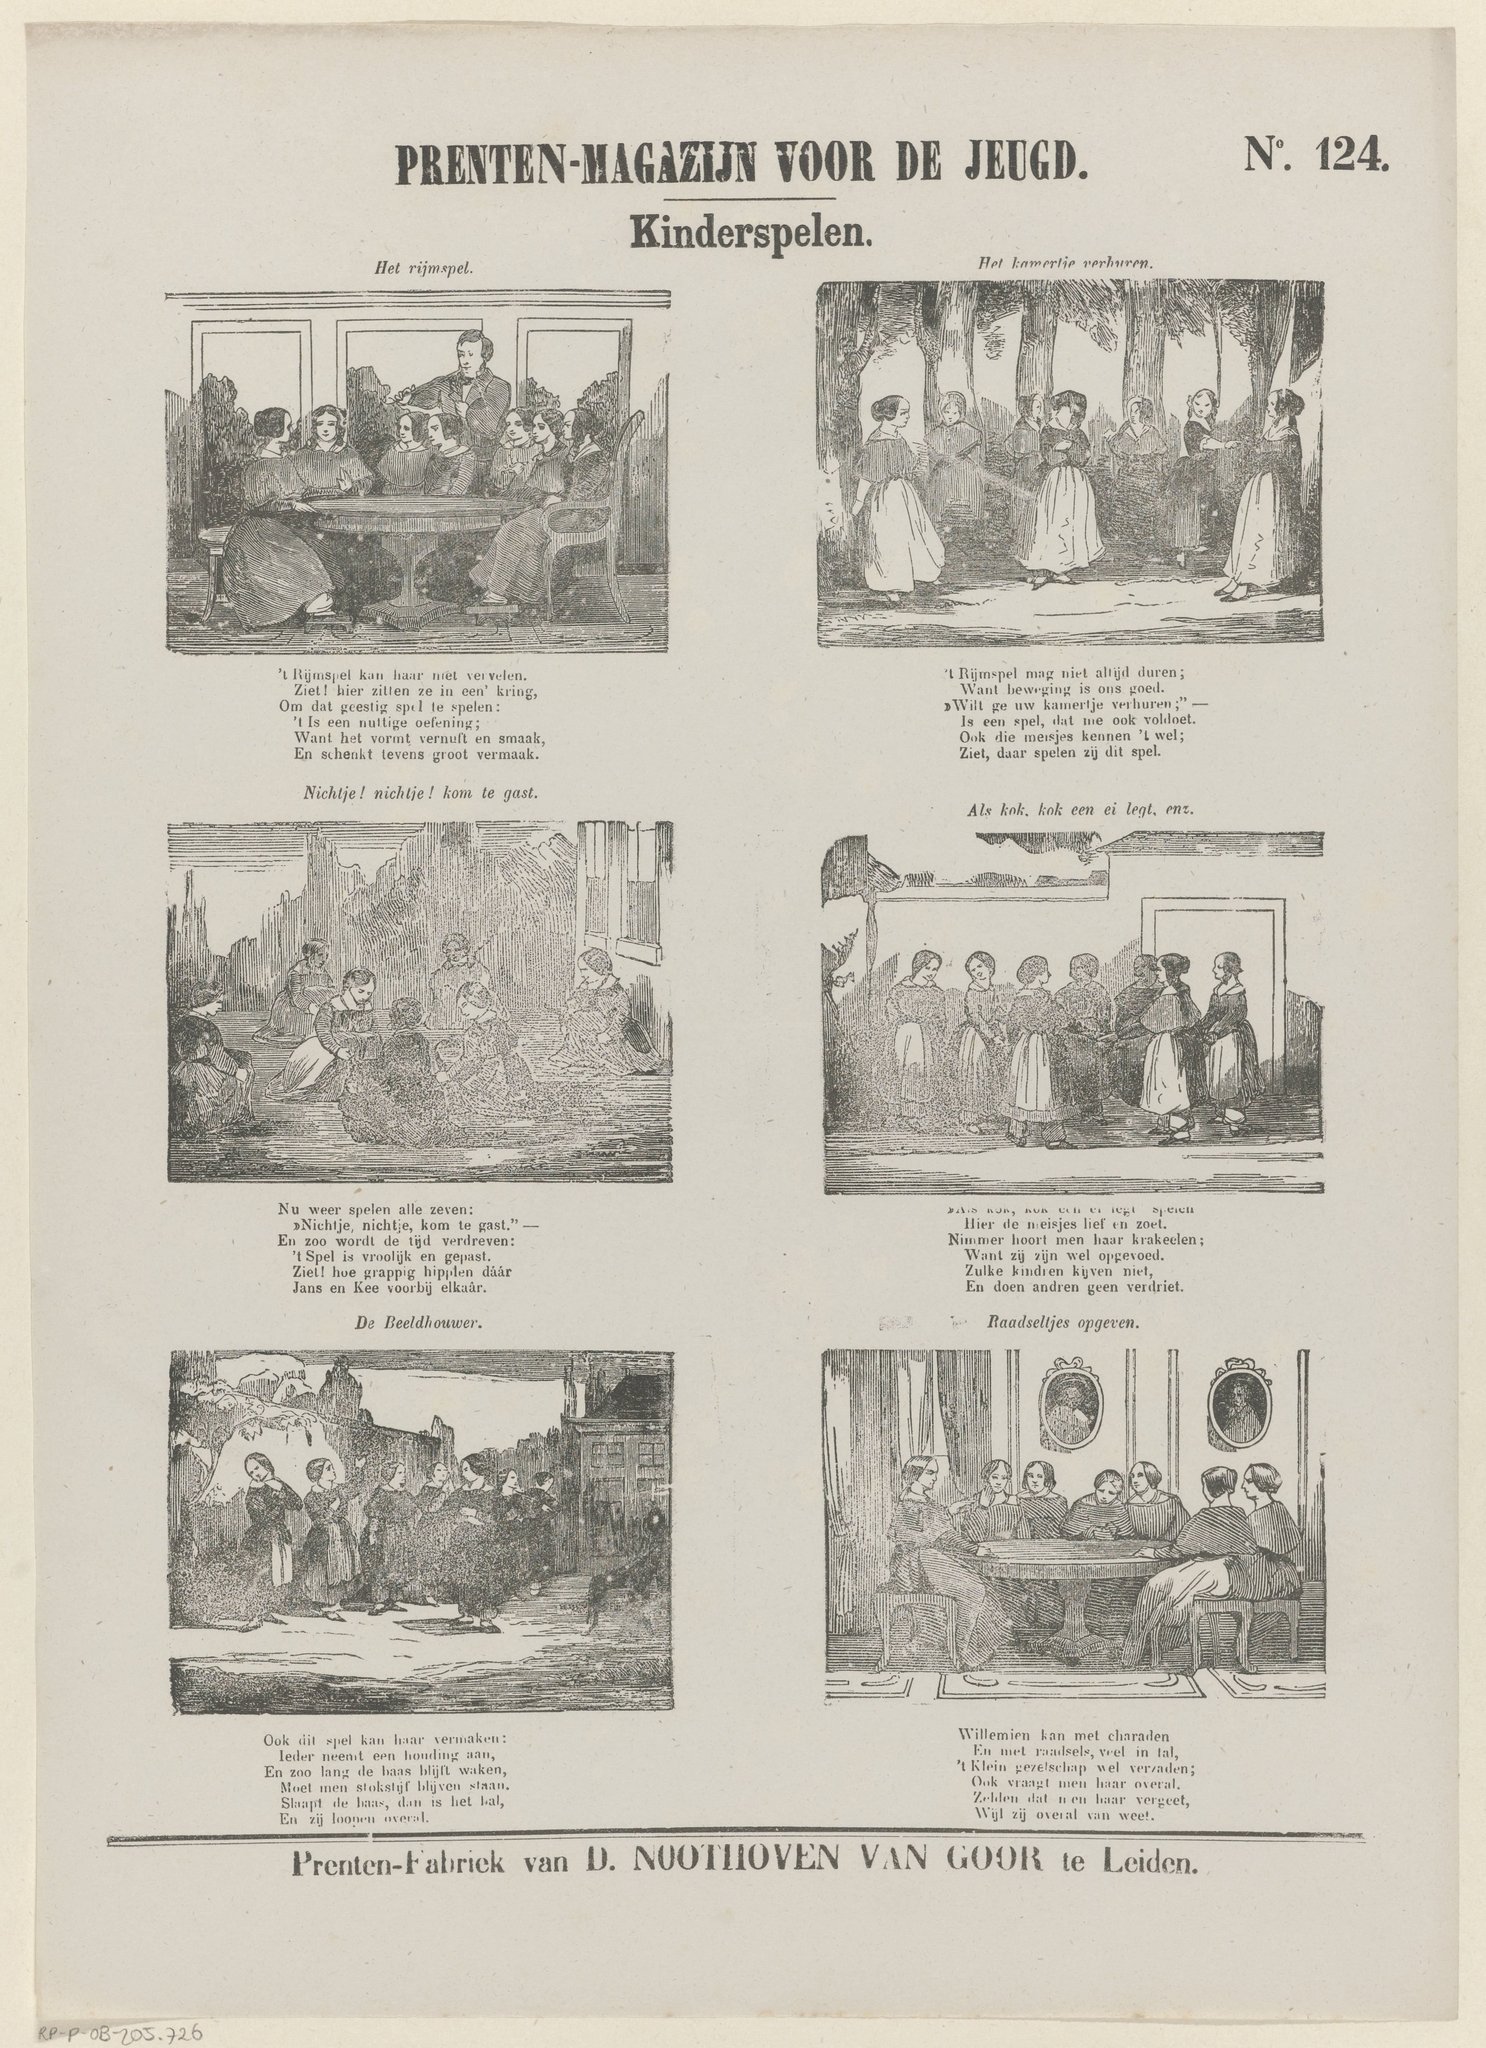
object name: popular print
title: Prenten-magazijn voor de jeugd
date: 1850-1881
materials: paper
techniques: letterpress printing, engraving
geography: netherlands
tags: children's games and plays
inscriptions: collector's mark: Lugt 2760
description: Blad met 6 voorstellingen van kinderspelen. Boven elke afbeelding een titel, onder elke afbeelding een zesregelig vers. Genummerd rechtsboven: No. 124.